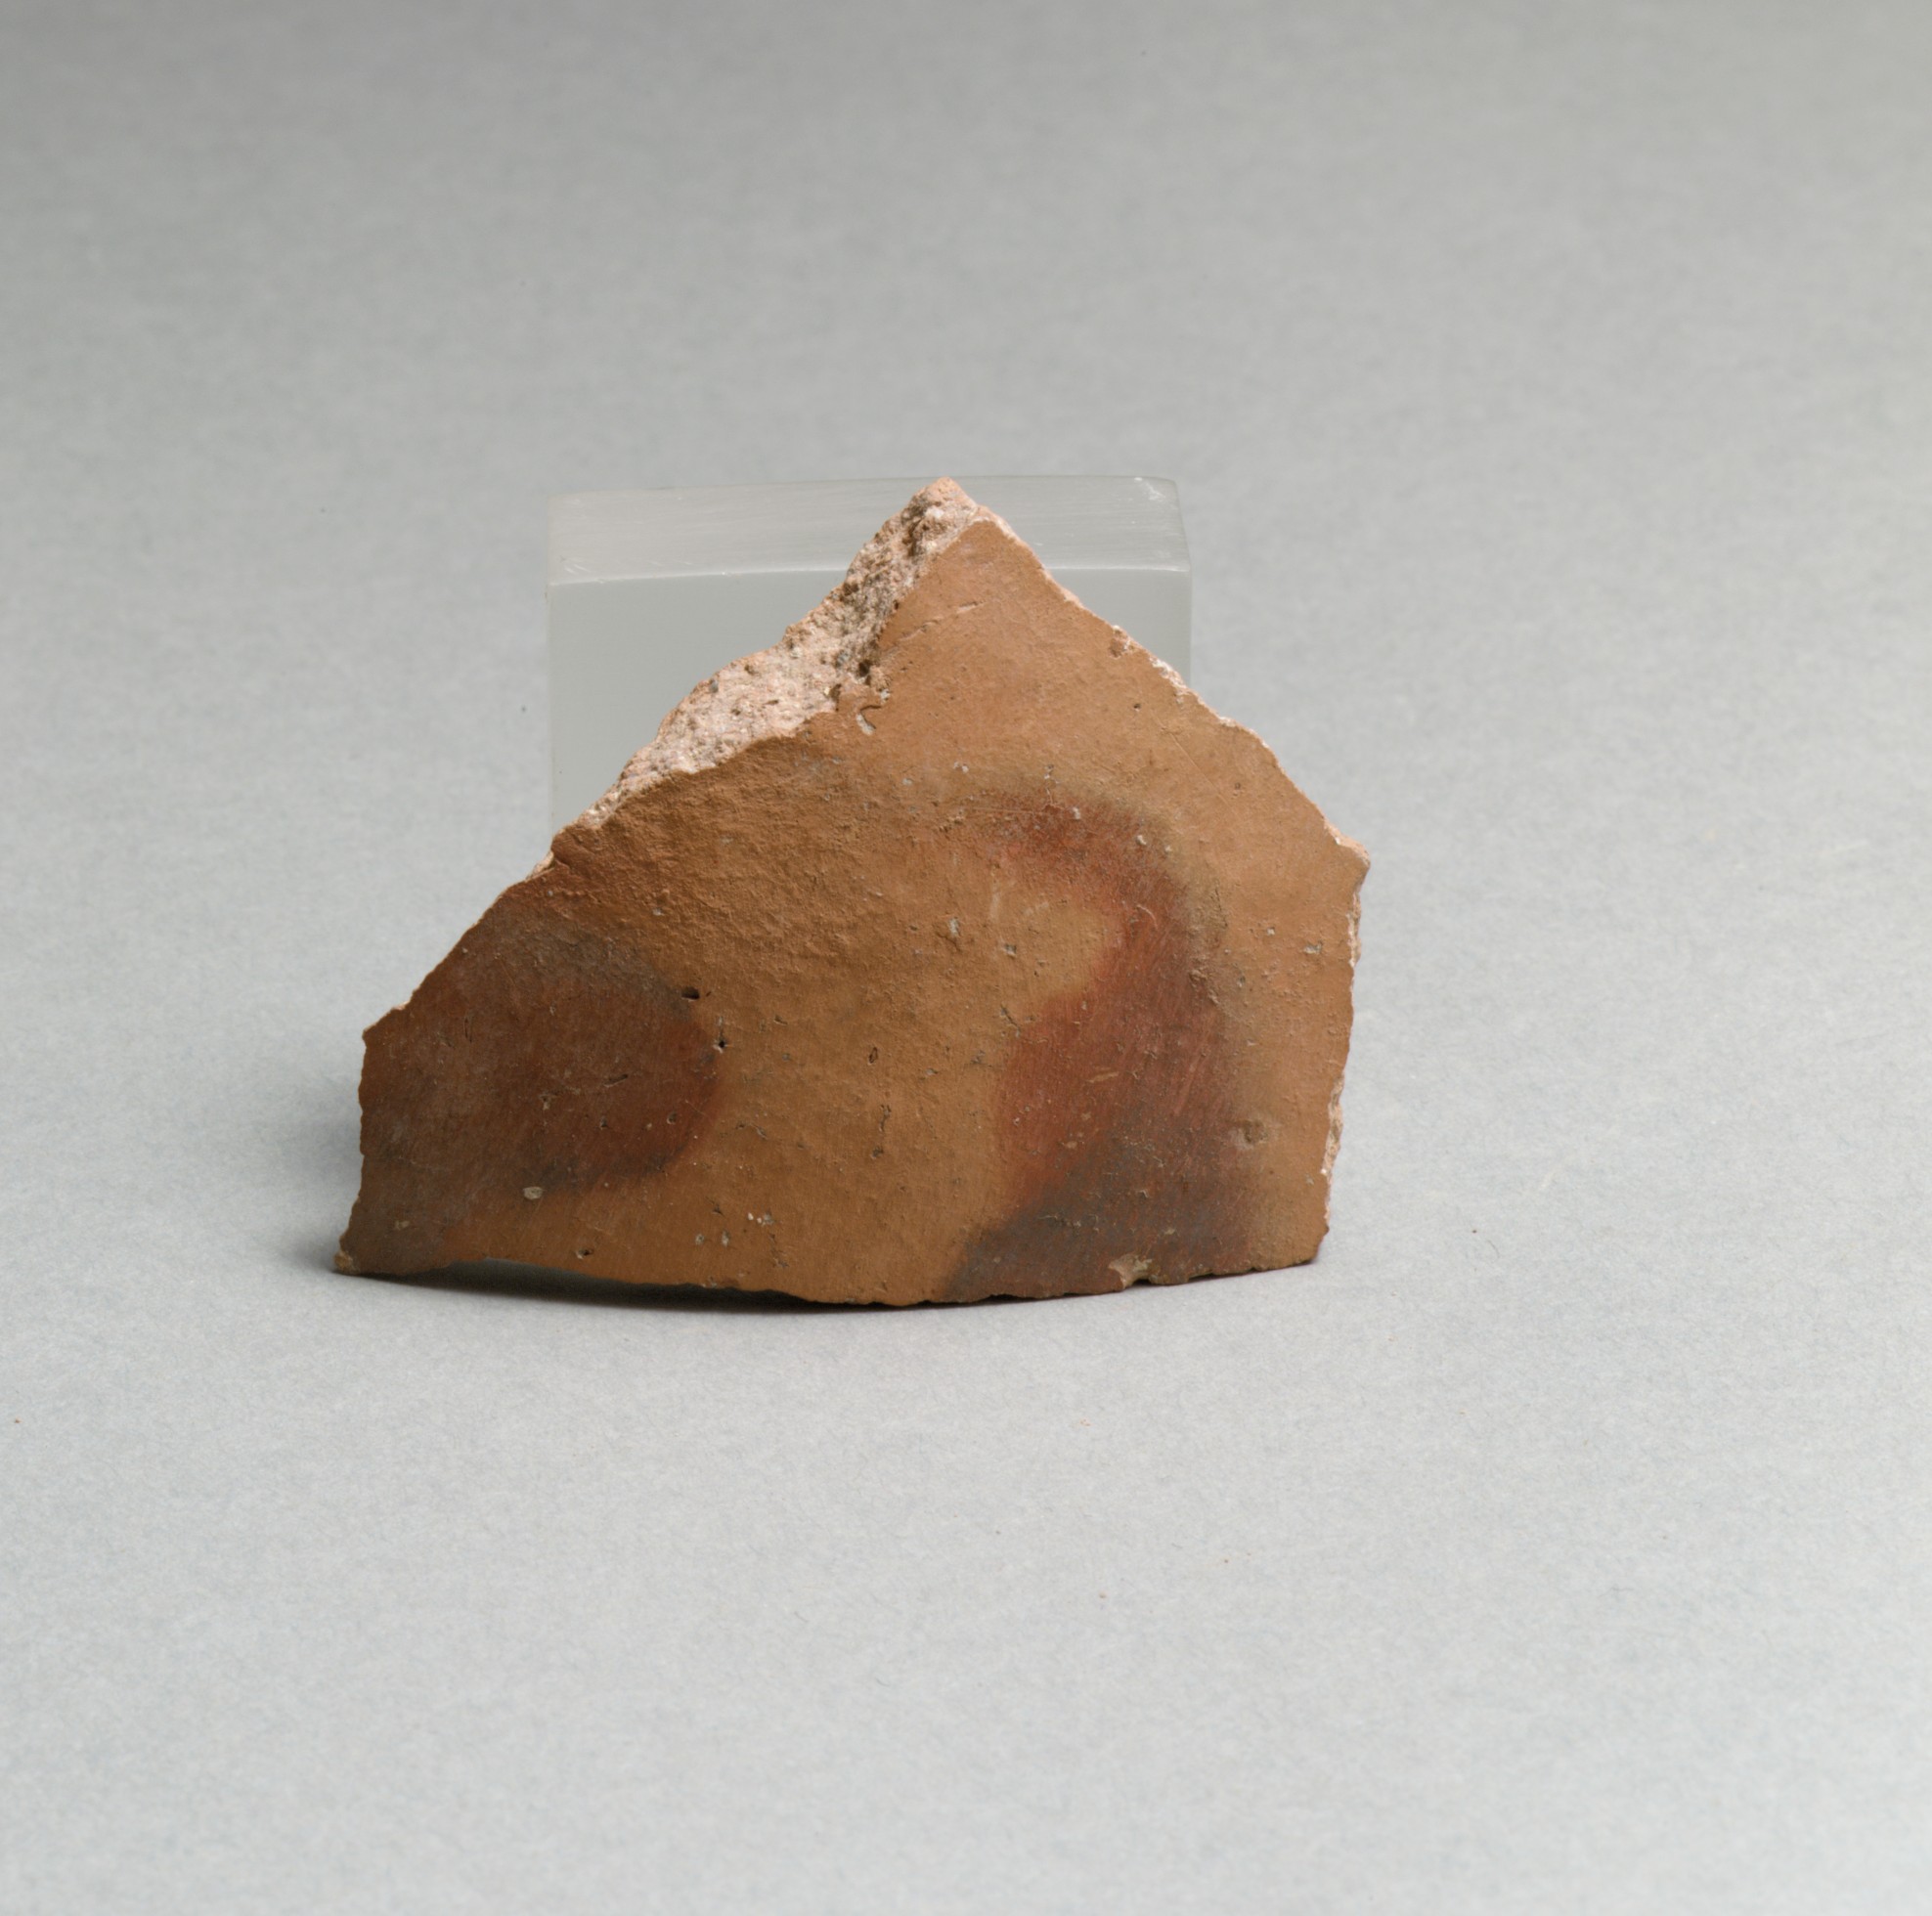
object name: vase fragment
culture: minoan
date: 2600-2000 BCE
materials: terracotta